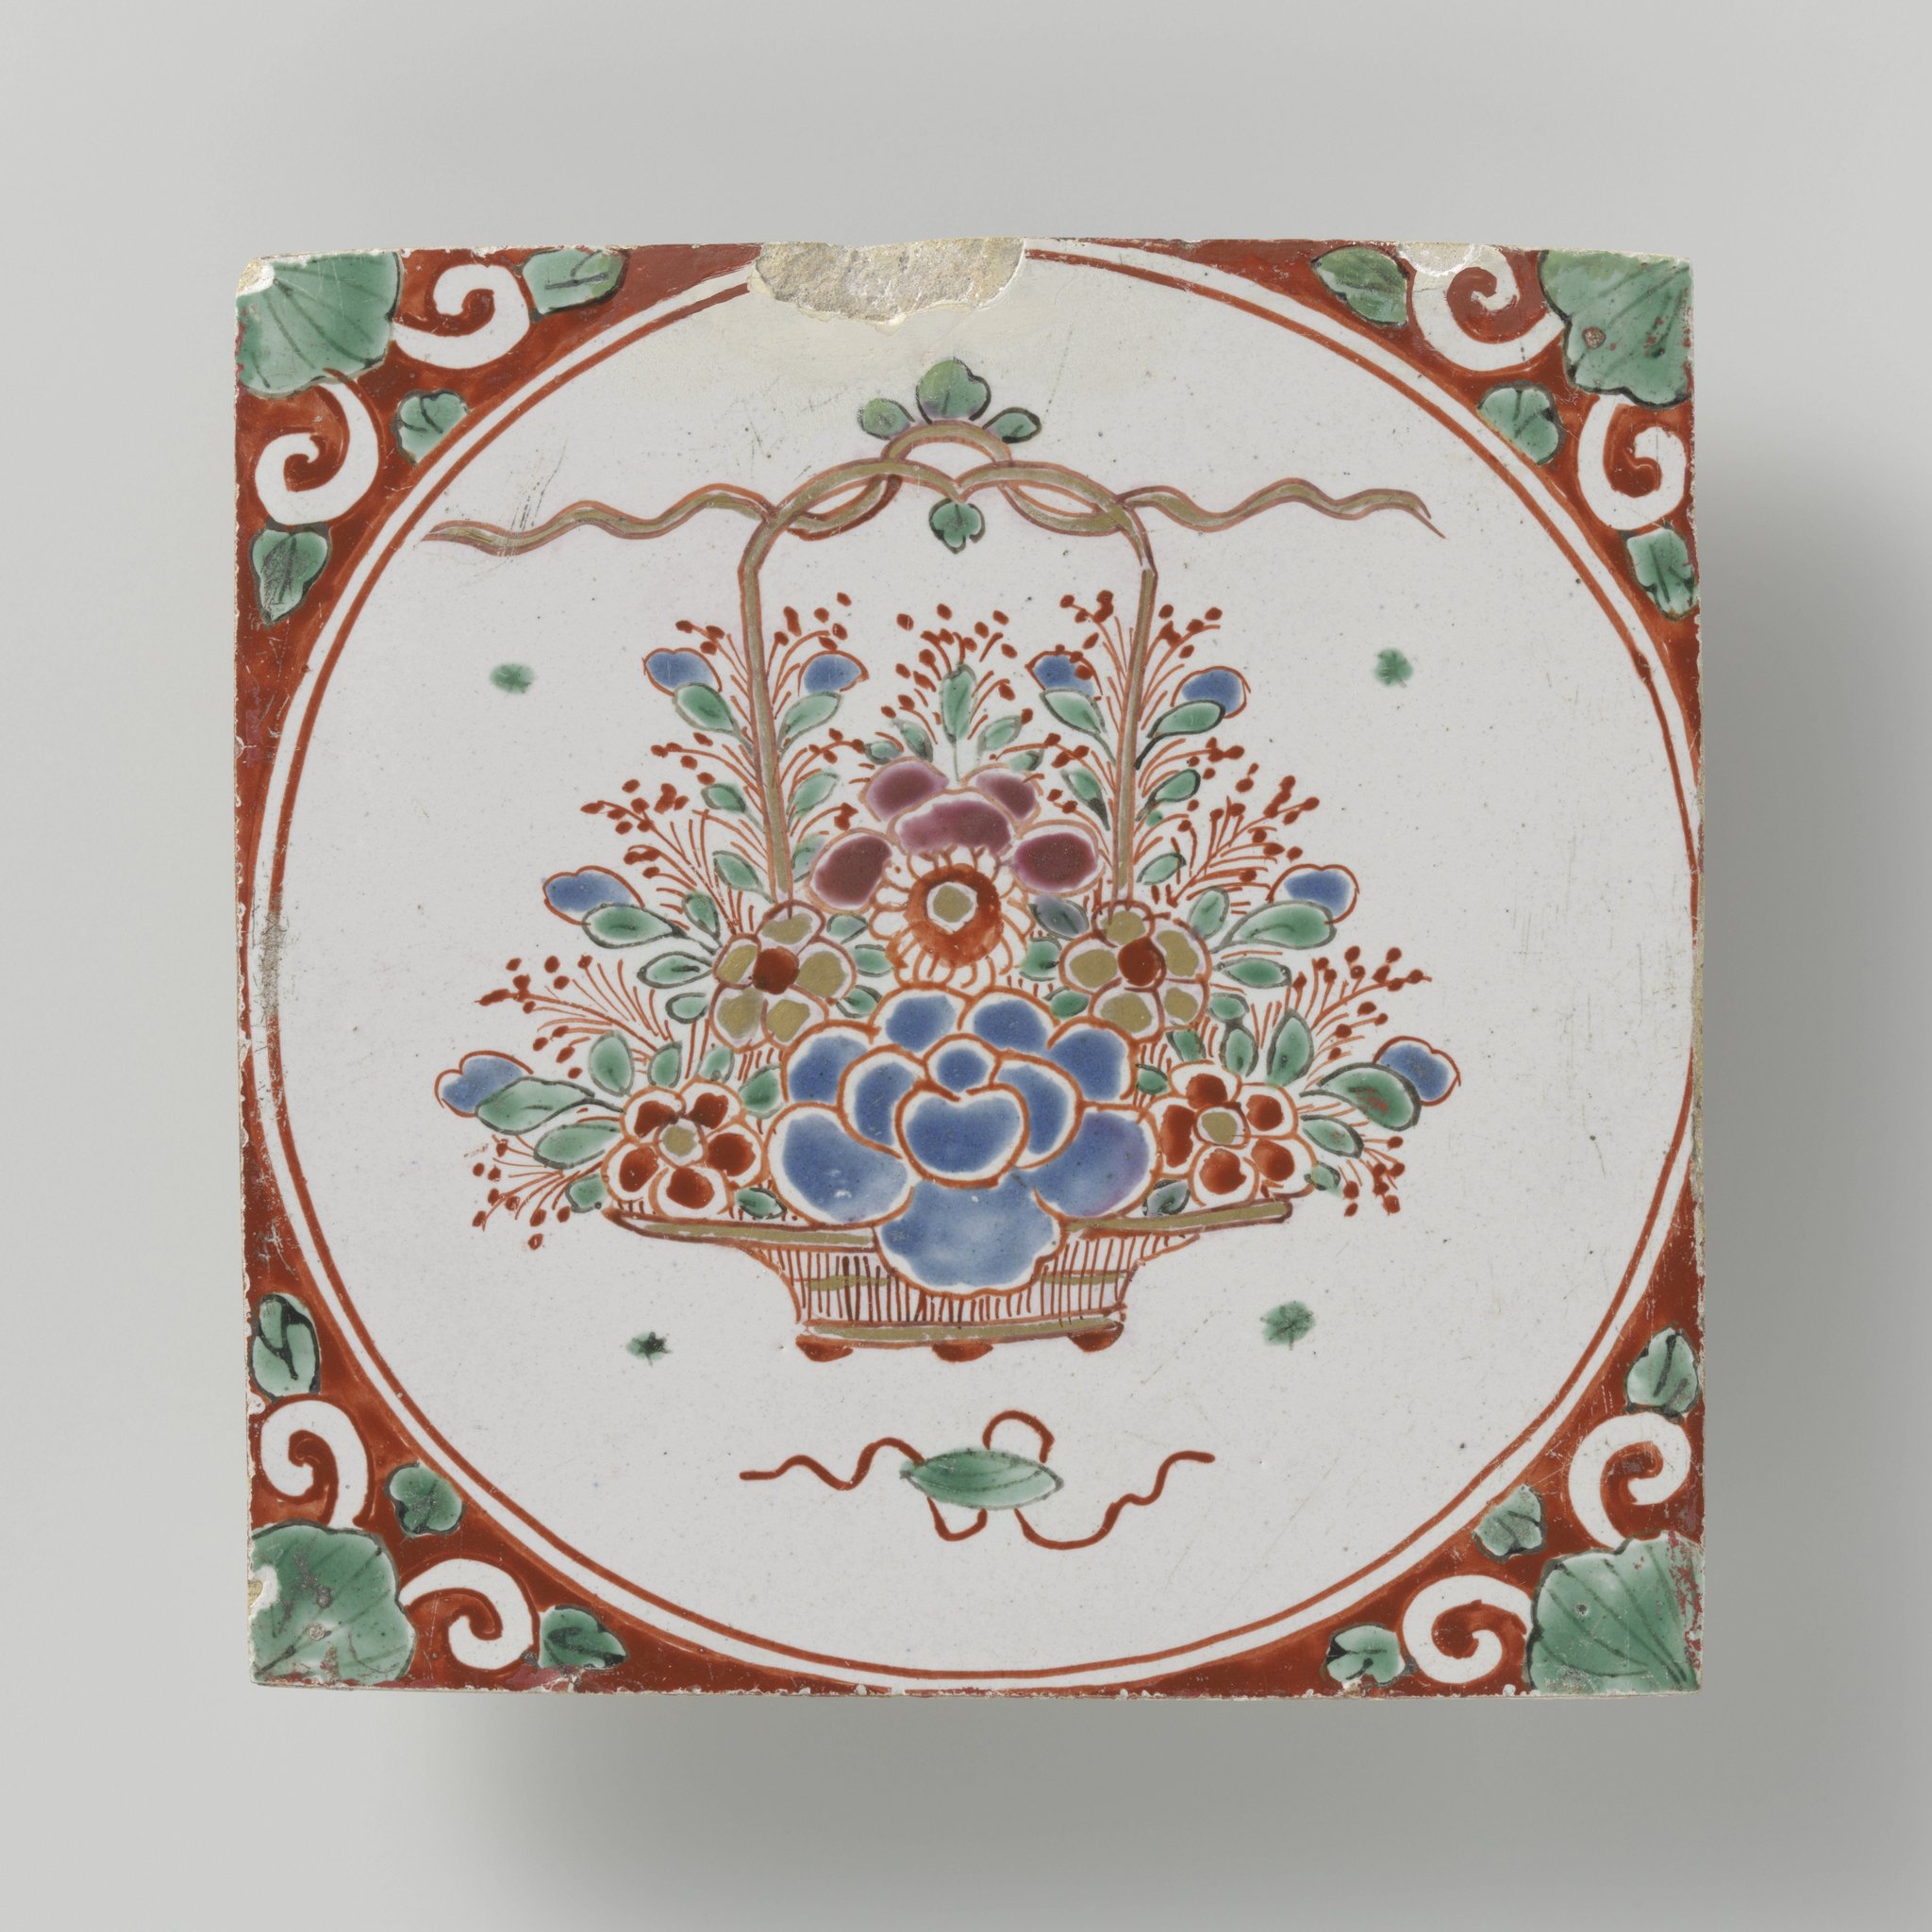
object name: tile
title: Tegel met veelkleurige bloemvaas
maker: Anonymous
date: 1720-1750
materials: faience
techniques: kiln, painted, polychromy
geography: delft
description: Tegel veelkleurig beschilderd met een bloemvaas binnen een cirkel. In de hoeken, bloemmotieven.